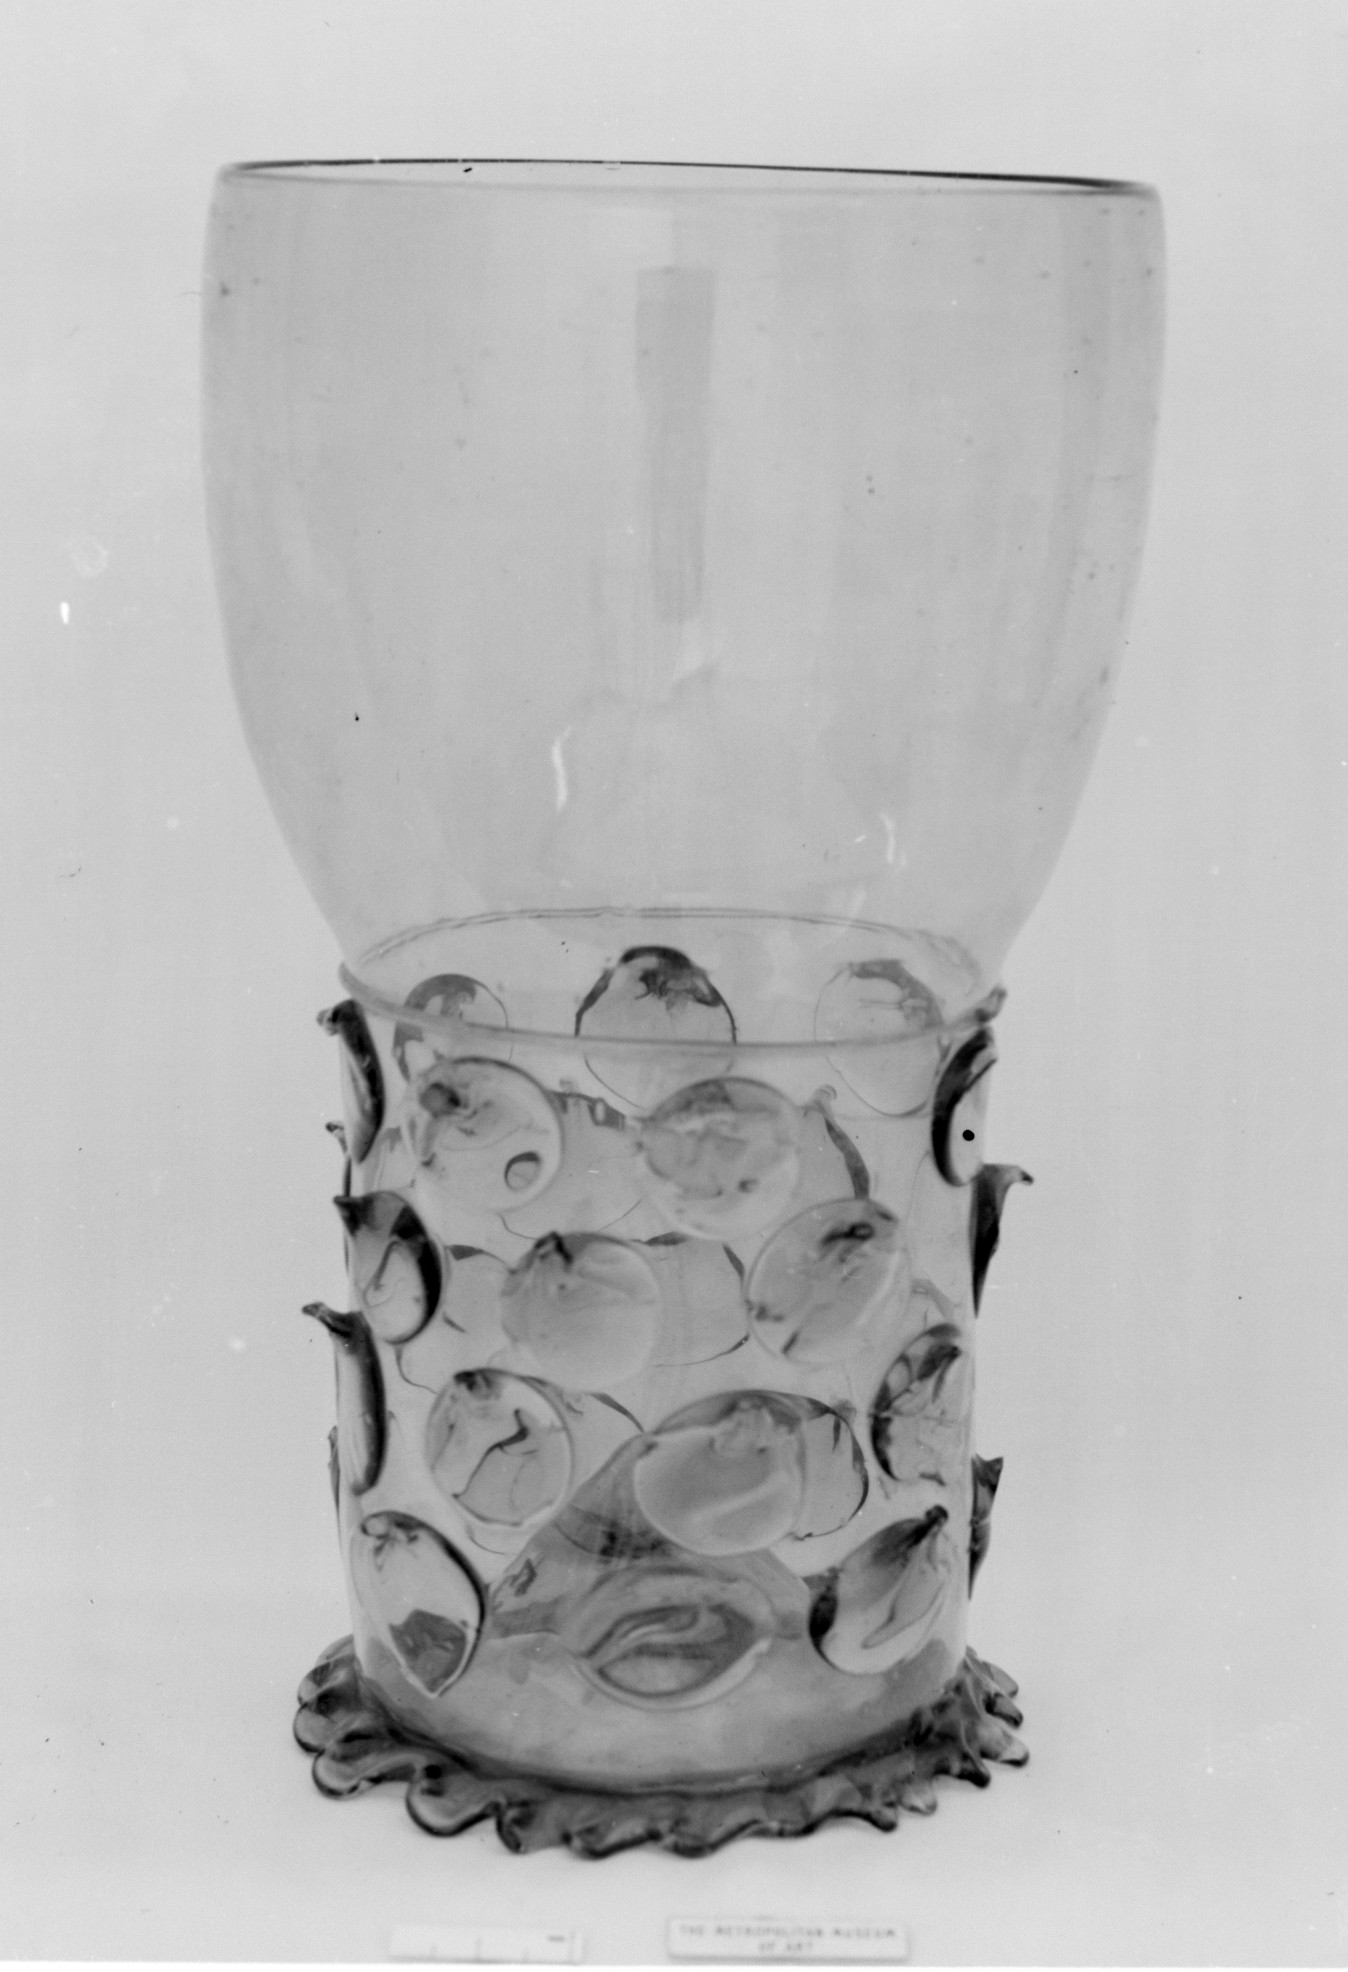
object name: goblet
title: Goblet (Roemer)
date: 1601-1633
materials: glass